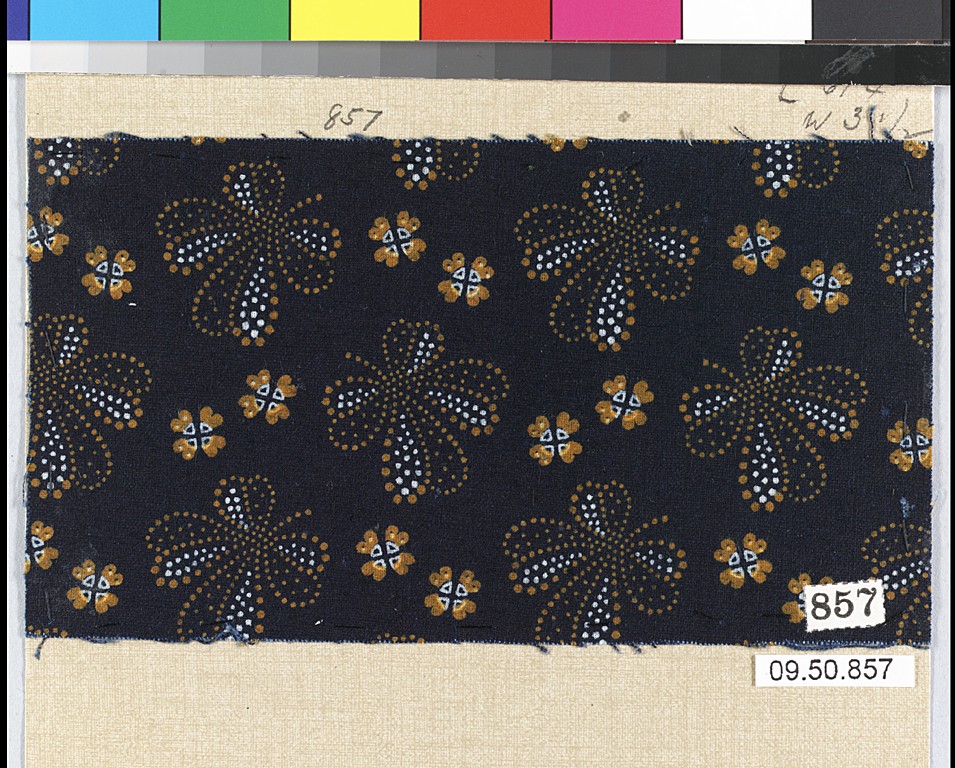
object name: piece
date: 1801-1900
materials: cotton